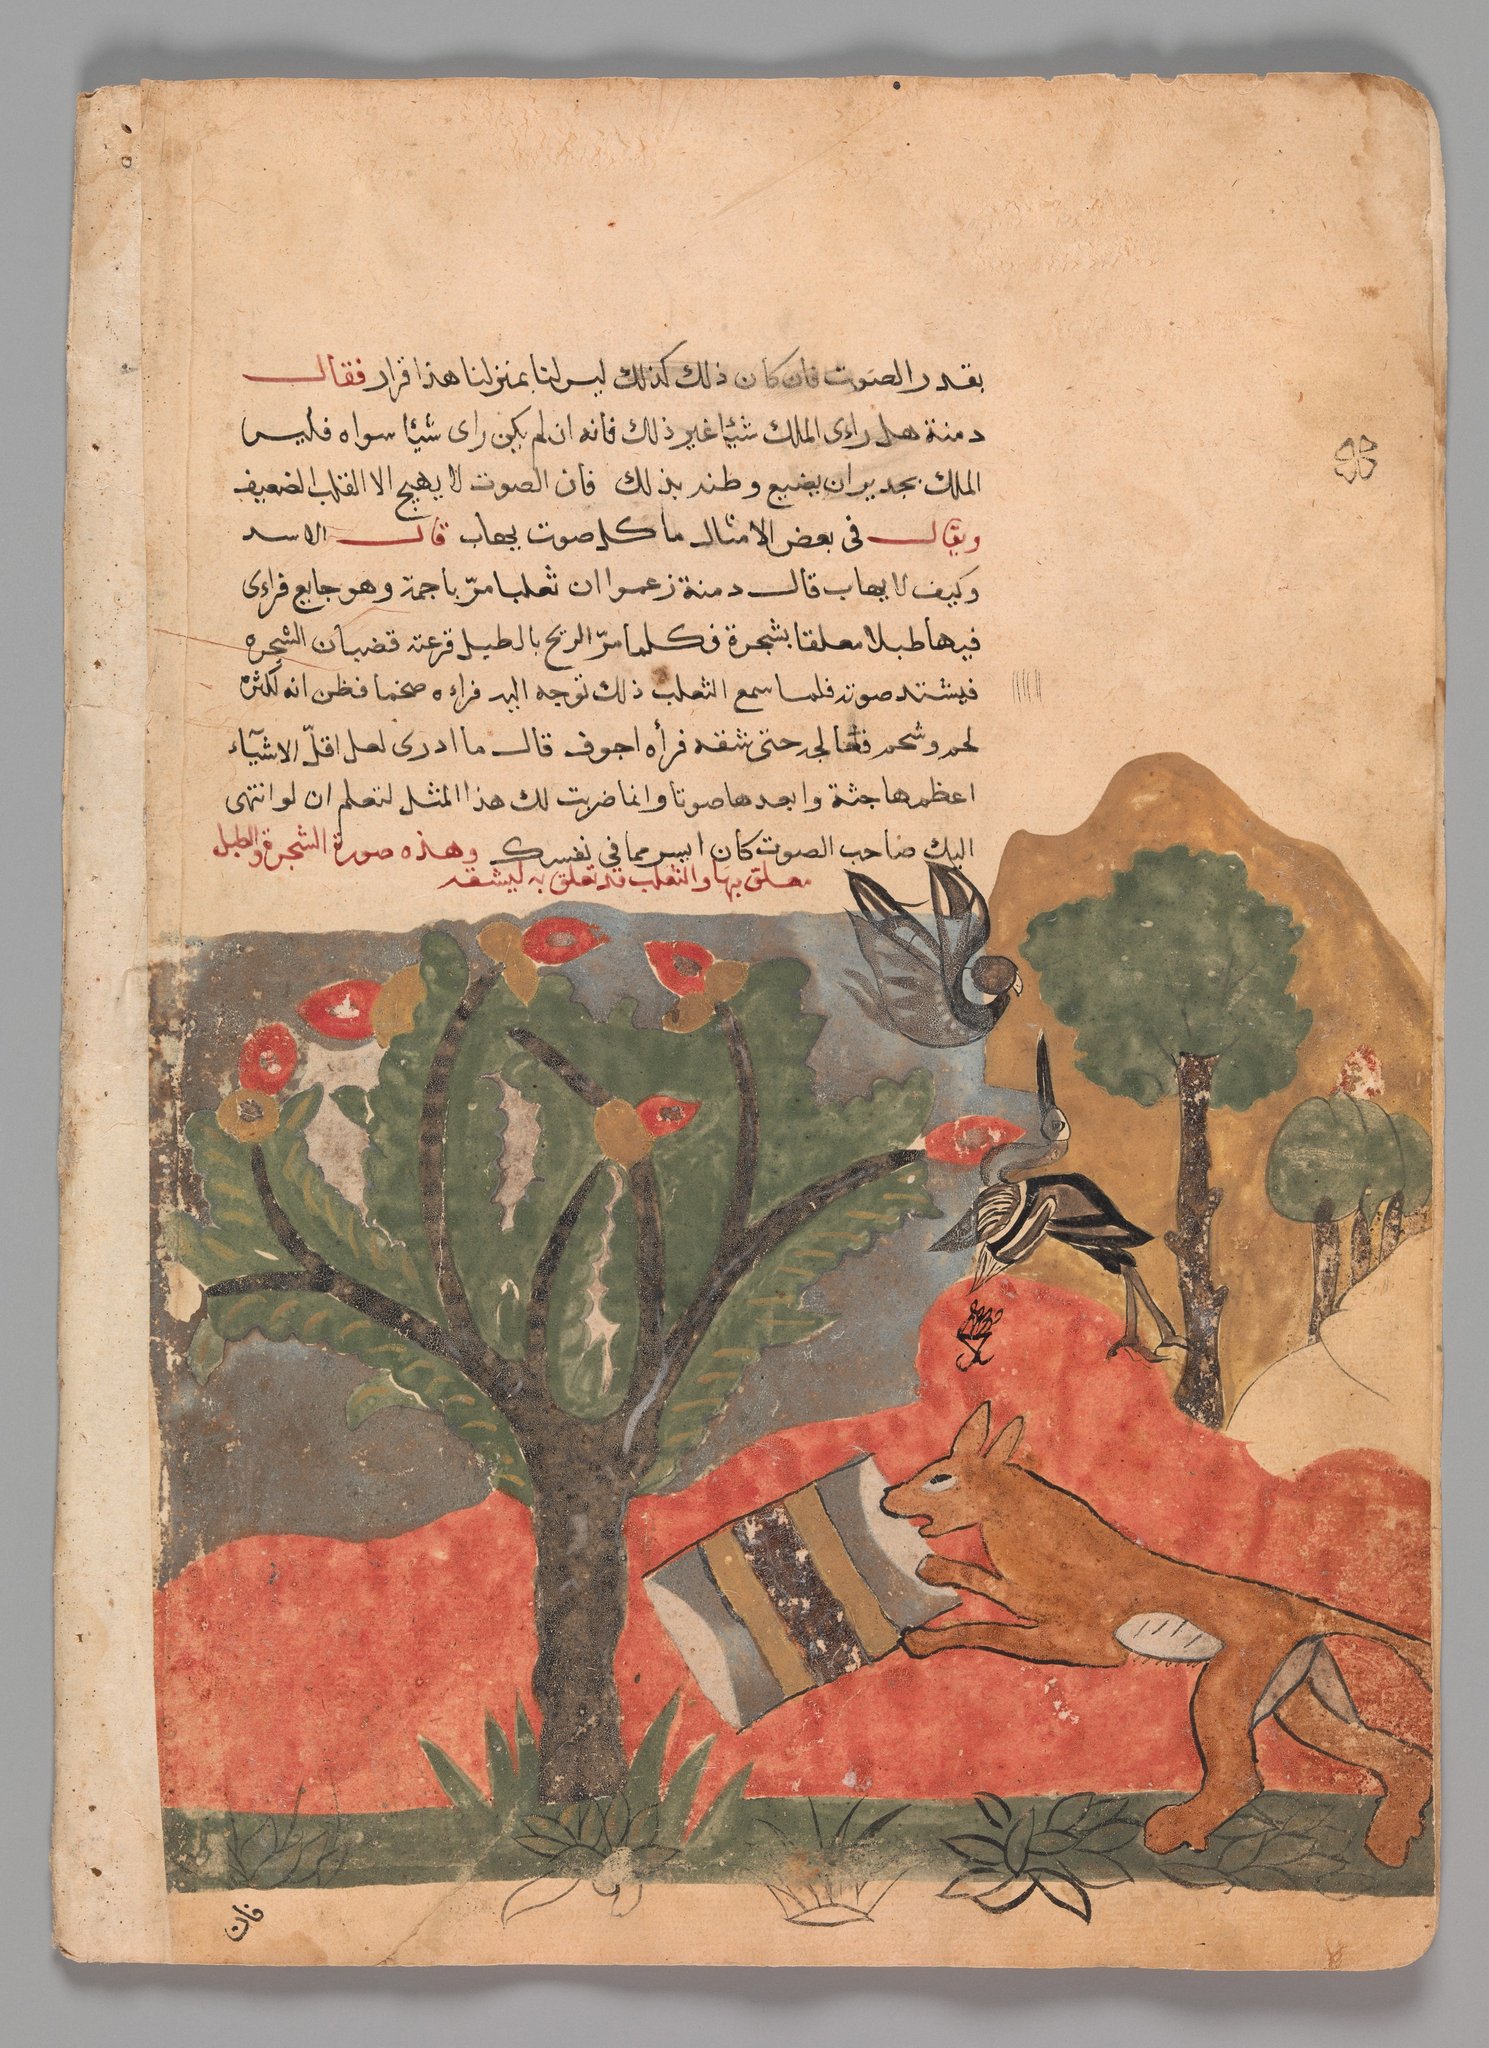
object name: folio from an illustrated manuscript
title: "The Fox and the Drum", Folio from a Kalila wa Dimna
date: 1526-1550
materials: ink, paper, watercolor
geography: india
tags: drums,foxes